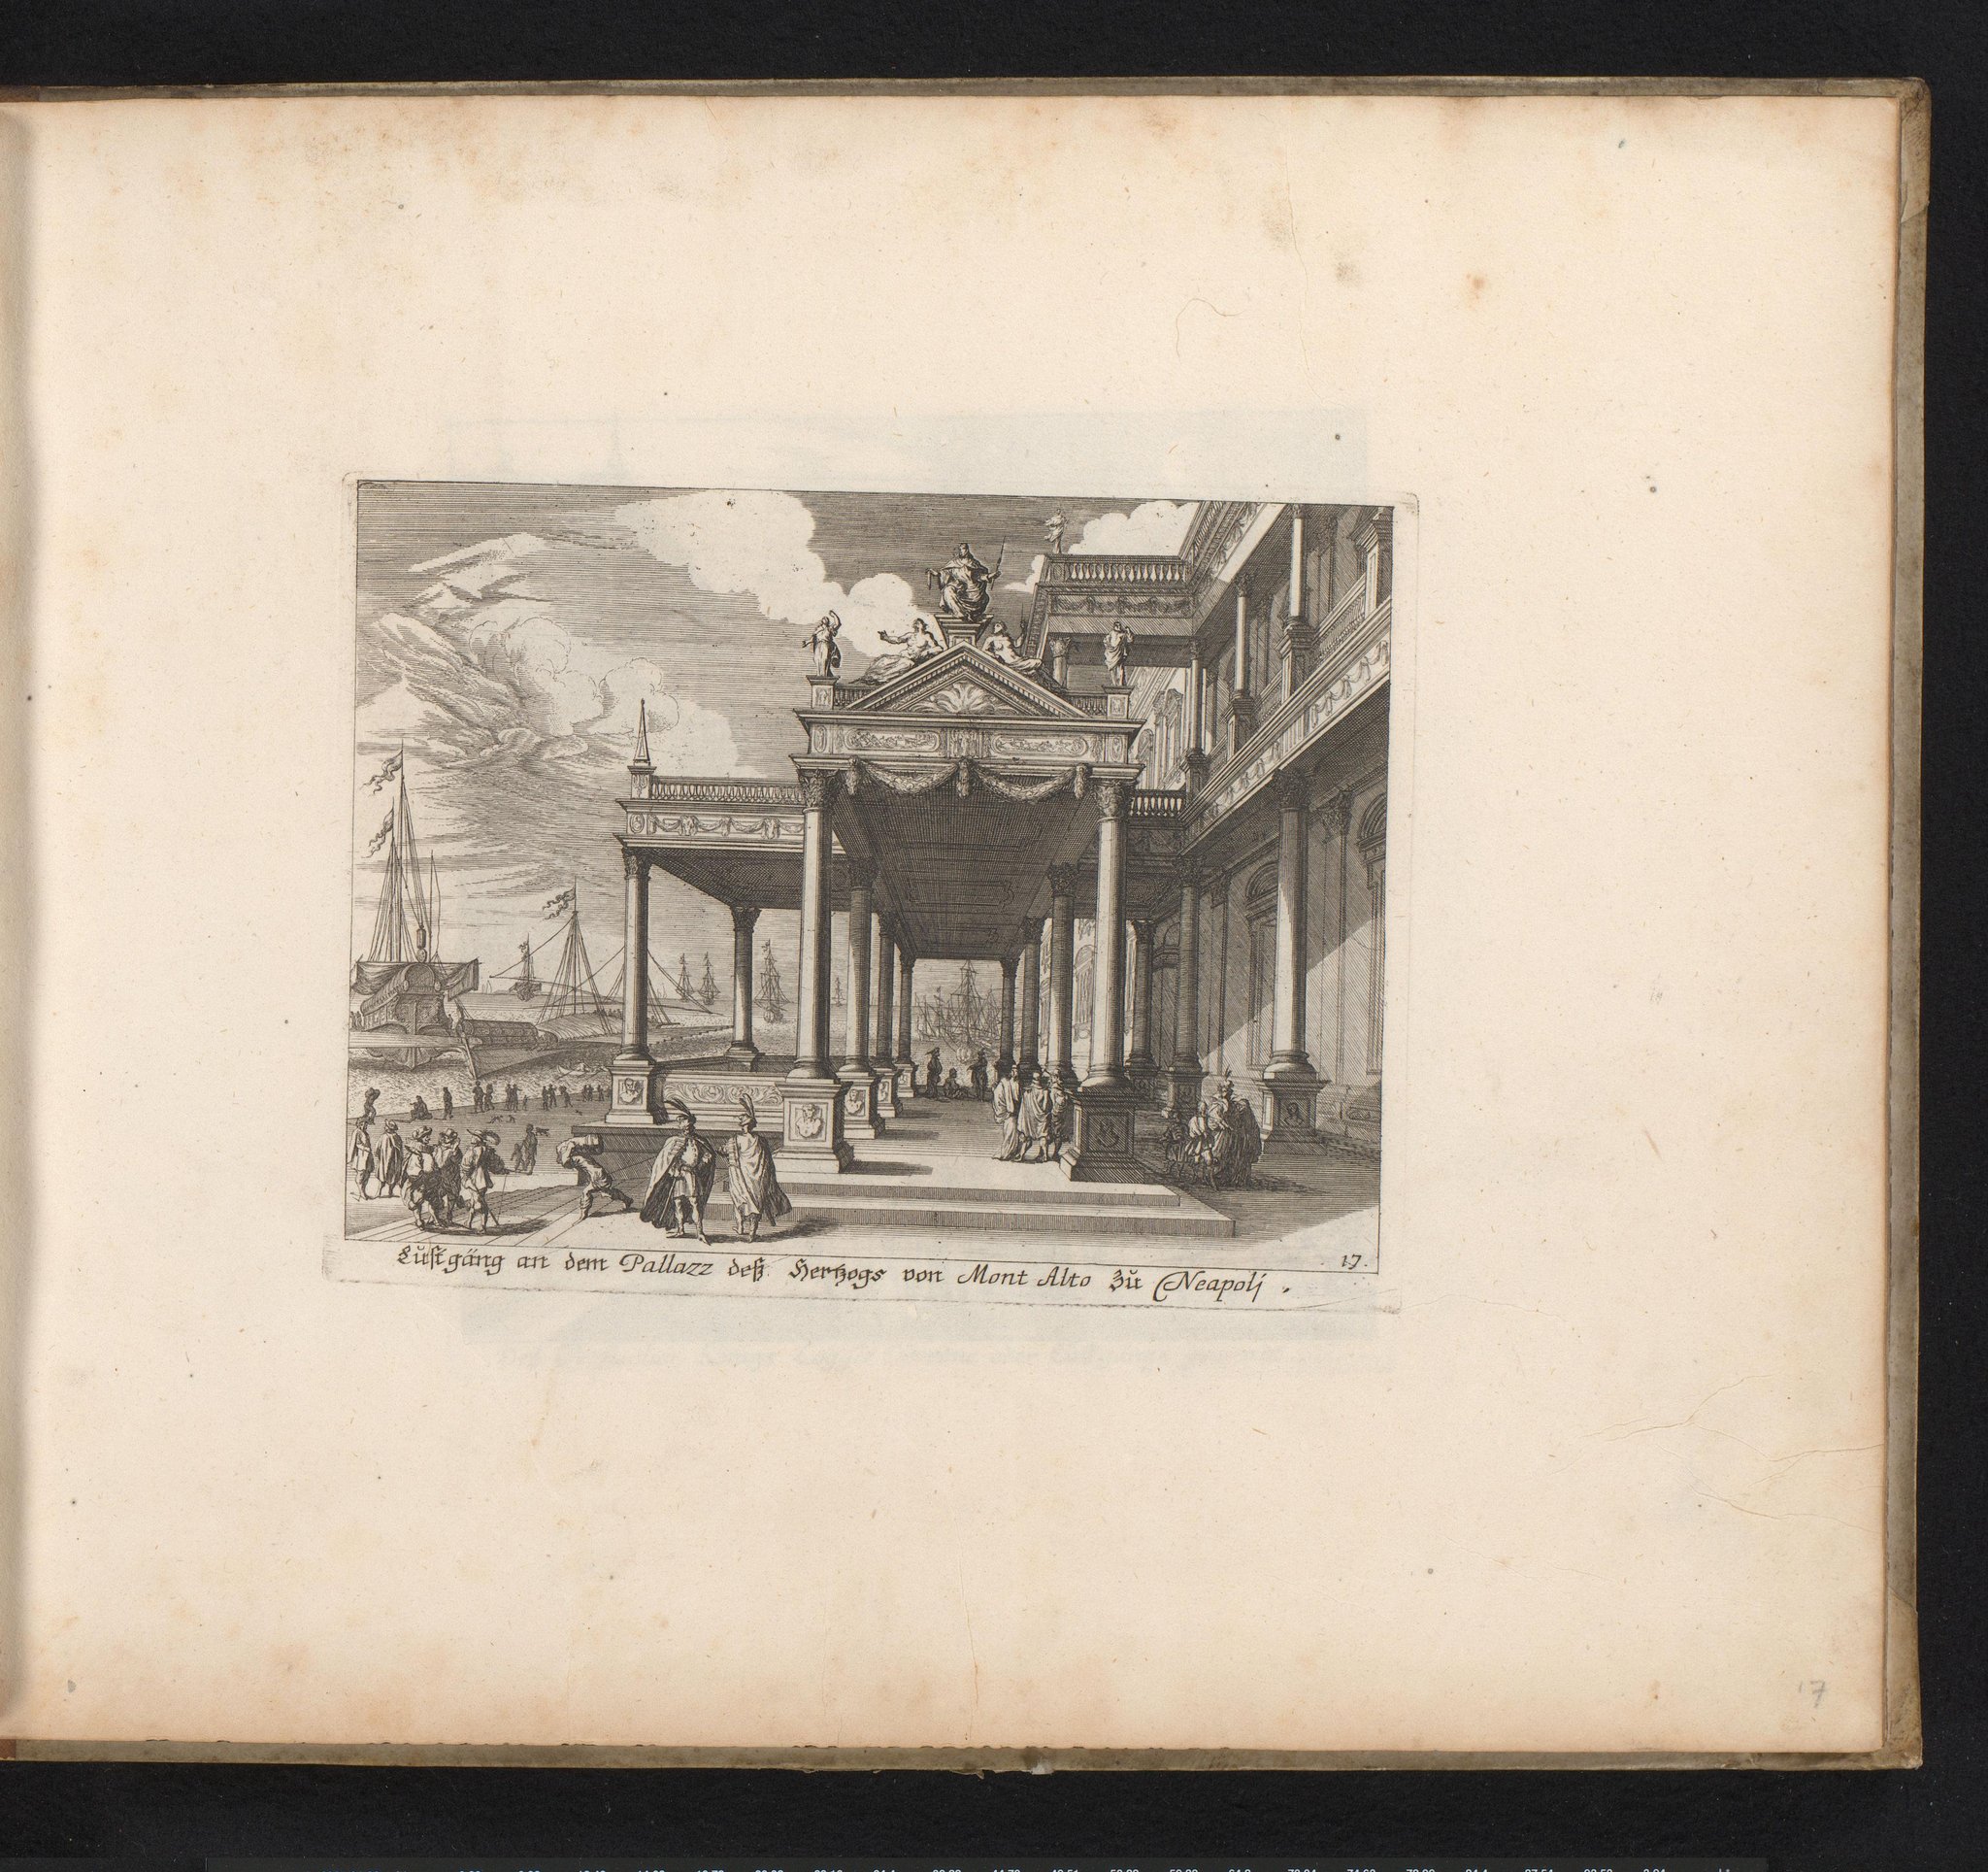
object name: album leaf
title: Gebouwen in Romeinse stijl aan een werf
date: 1670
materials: paper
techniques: etching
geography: augsburg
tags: pier, quay, wharf, village square, place, naples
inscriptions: collector's mark: Lugt 2228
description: Tekst in het Duits in de ondermarge. Rechtsonder genummerd: 17. Prent maakt deel uit van een album.